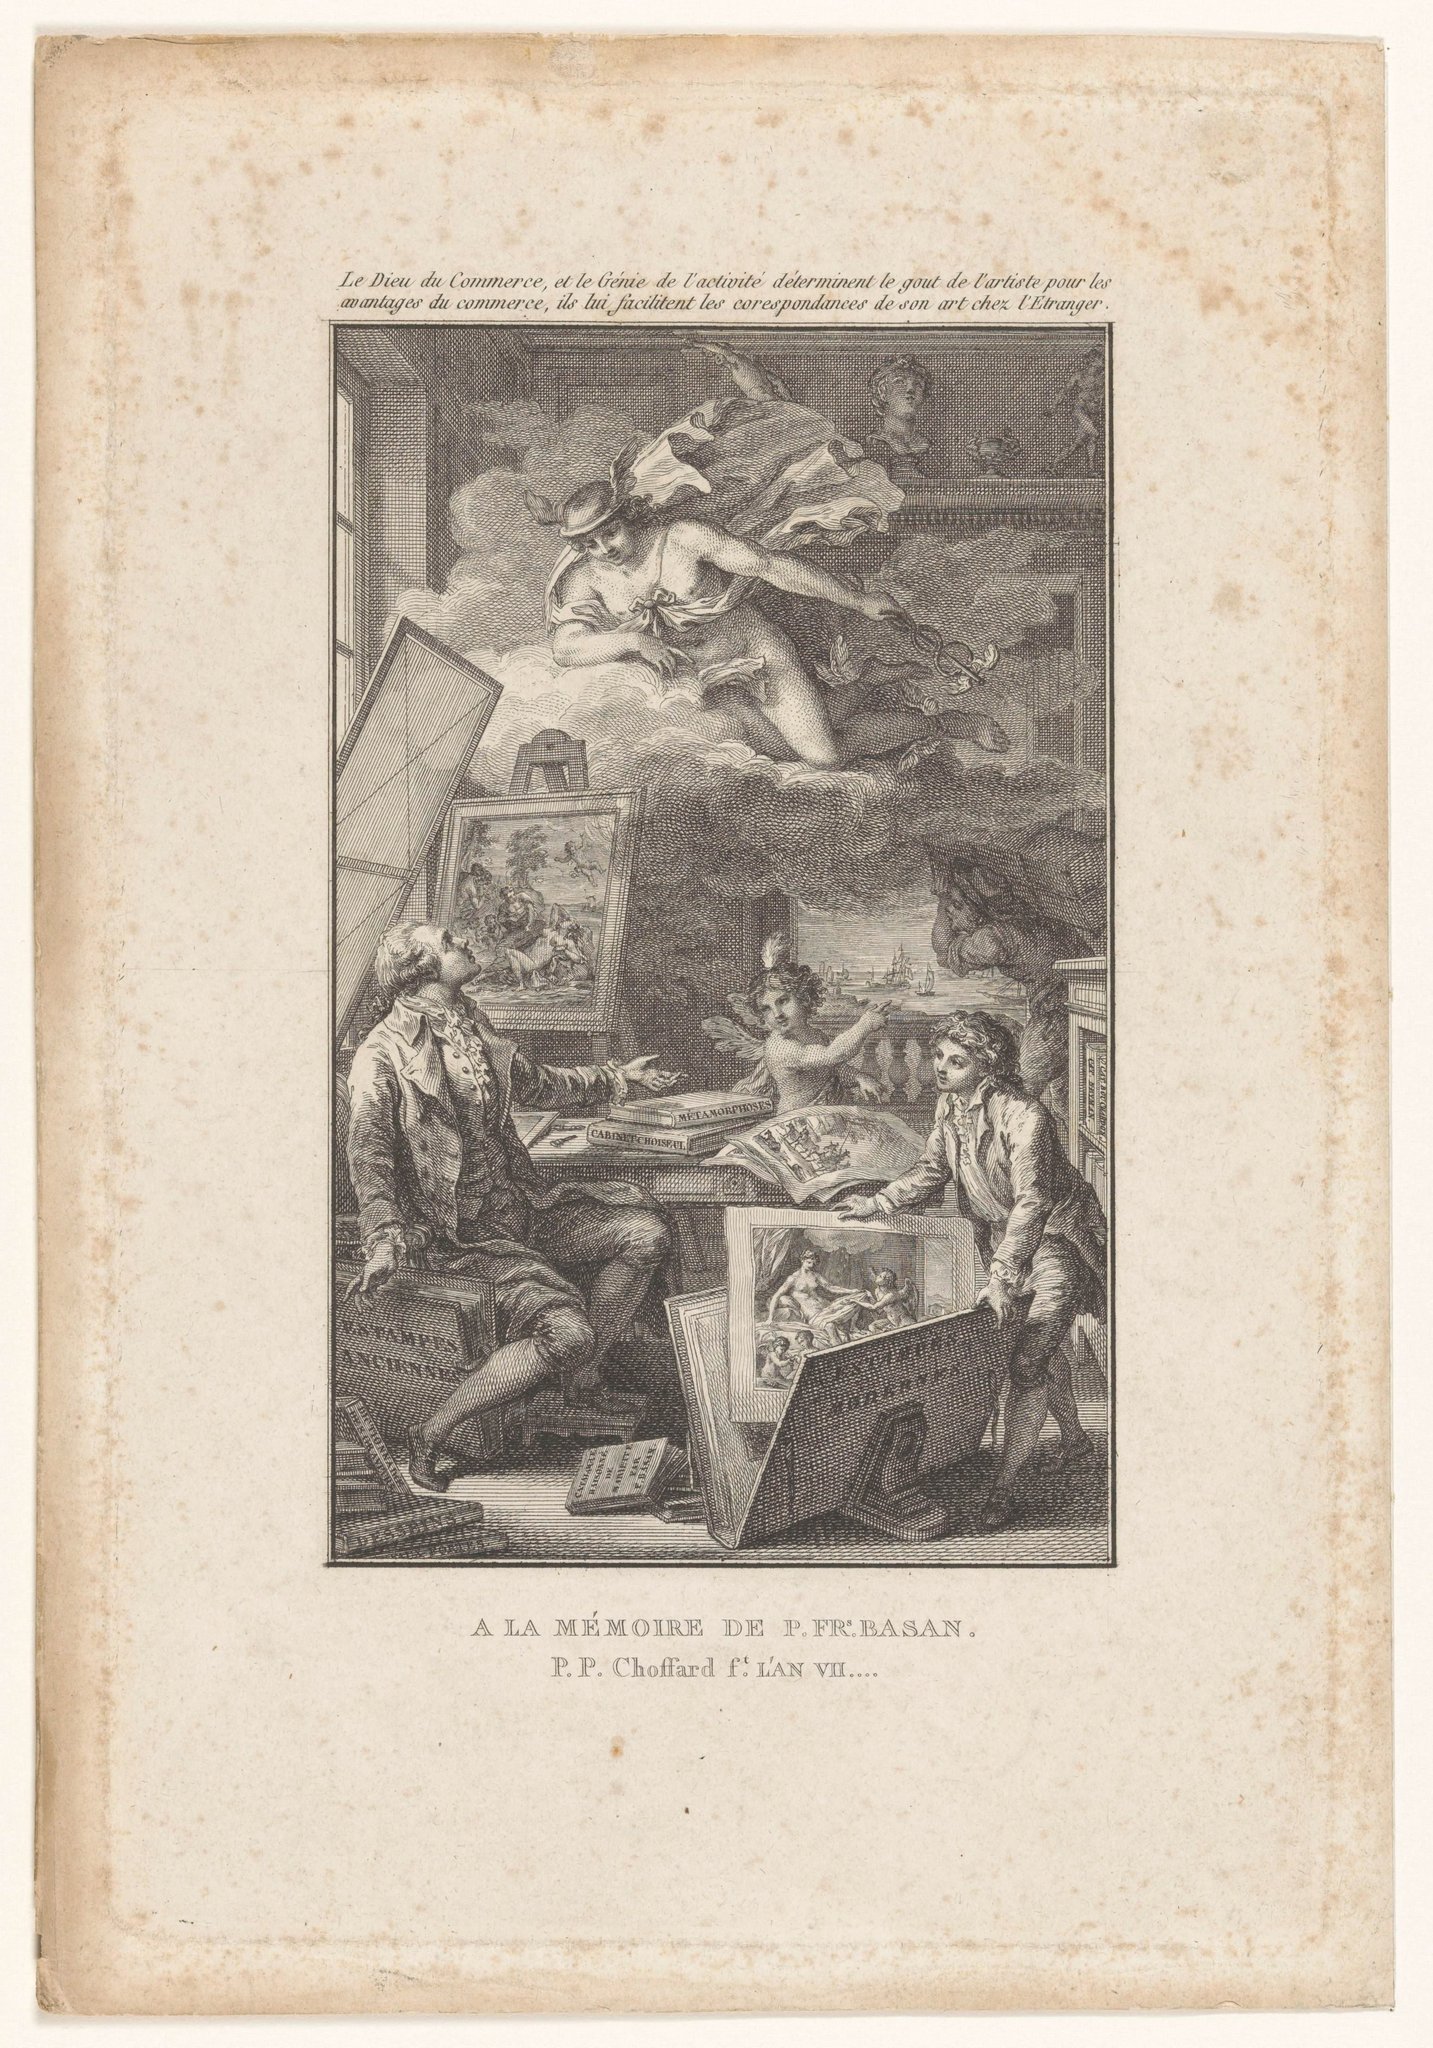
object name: print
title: A la mémoire de P. Frs. Basan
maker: pierre philippe choffard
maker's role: print maker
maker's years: 1730-1809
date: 1798-1799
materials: paper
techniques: etching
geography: paris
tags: publisher, pierre françois basan, (story of) mercury (hermes), art dealer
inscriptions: collector's mark: Lugt 4779, collector's mark: Lugt 2228, collector's mark: Lugt 4780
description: De Franse graveur, uitgever en kunstverkoper Pierre-François Basan in een interieur, omgeven door boeken, prenten en schilderijen. Vanuit de lucht daalt Hermes, god van de handel, op hem neer.